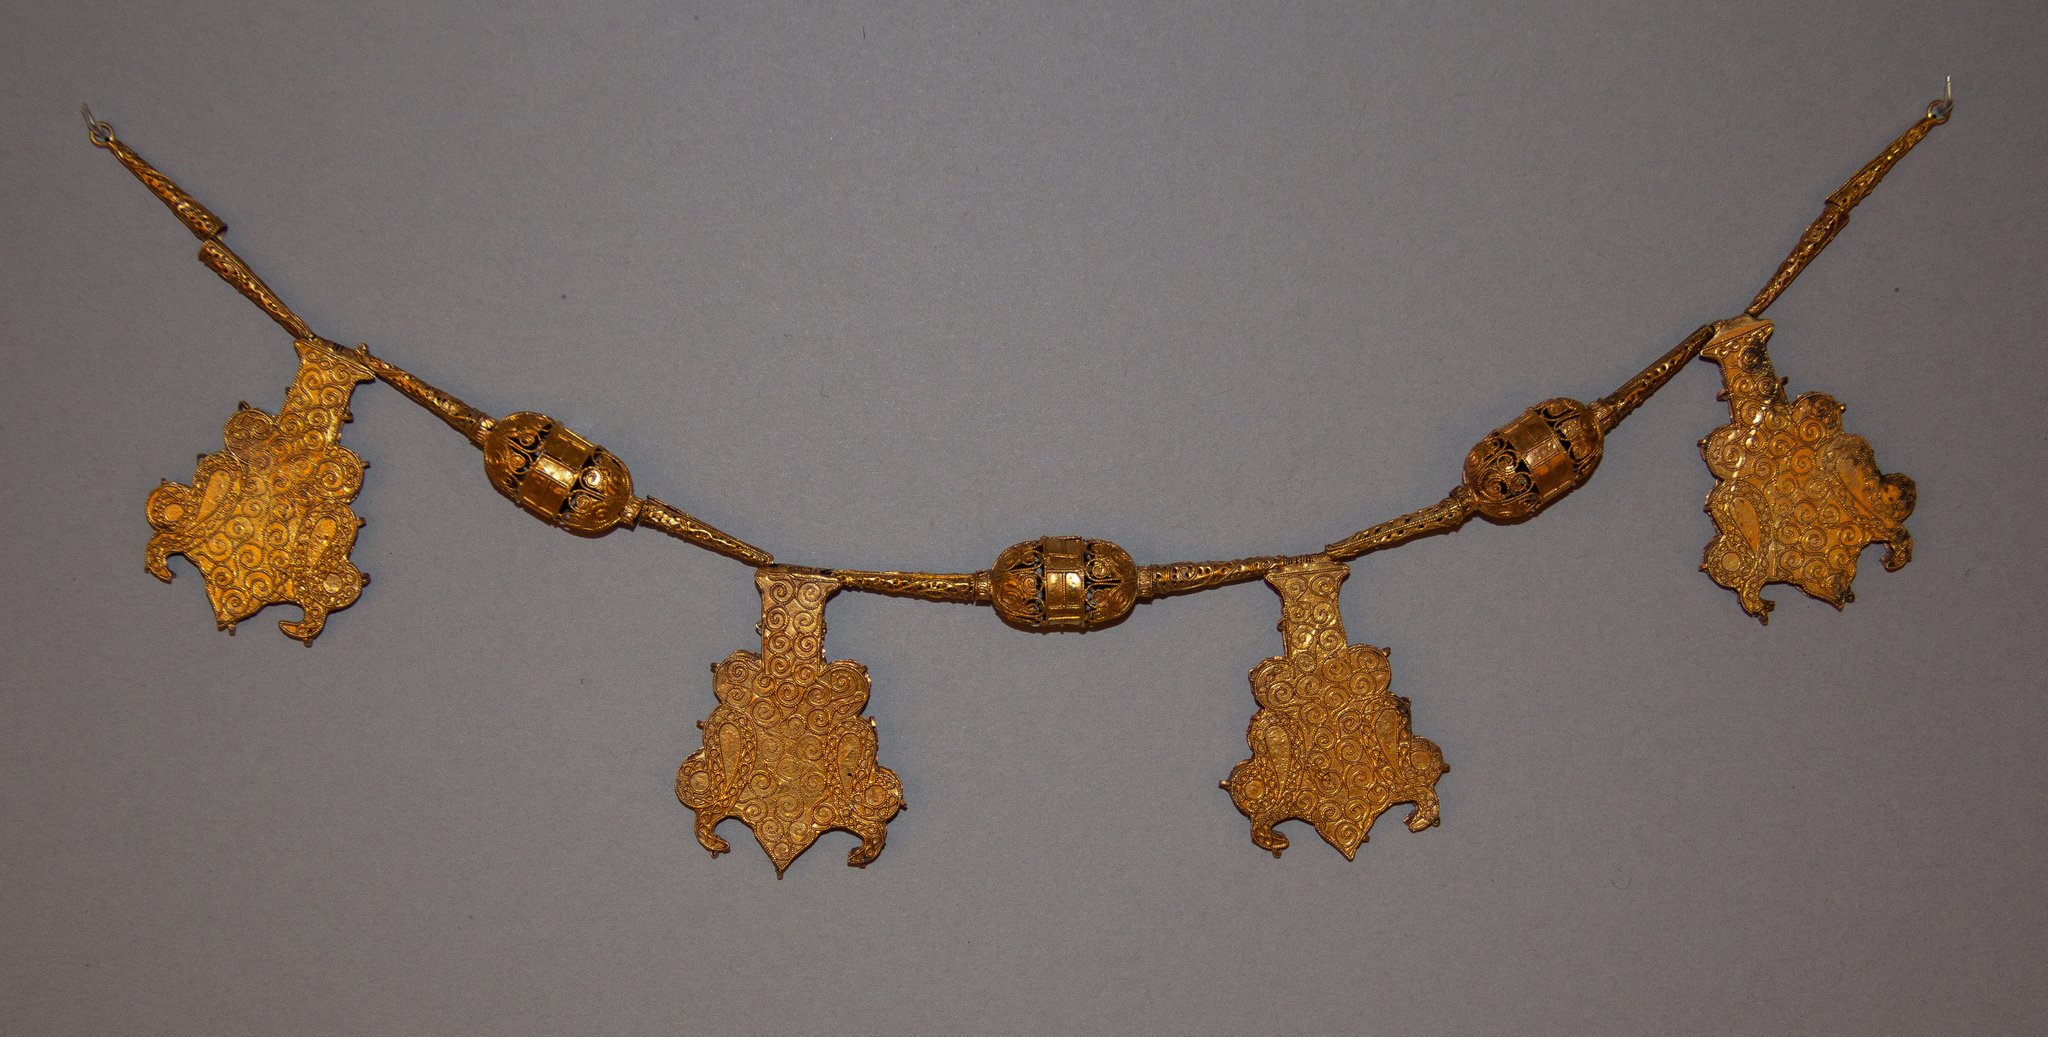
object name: necklace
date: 1301-1500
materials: gold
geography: spain